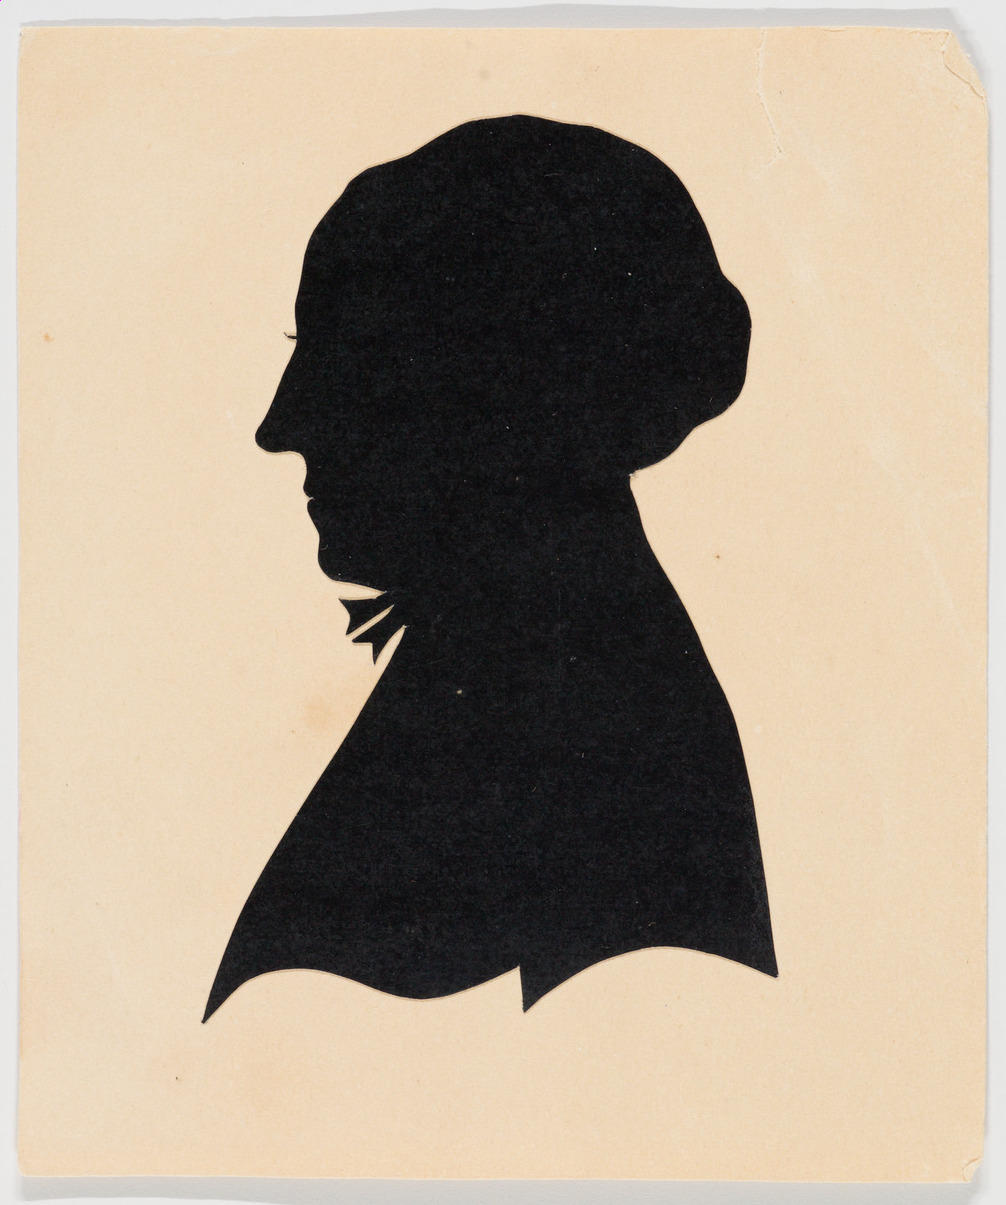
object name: cut paper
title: Unidentified profile portrait, woman facing left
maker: anonymous, german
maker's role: artist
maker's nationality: german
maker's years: 1400-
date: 1773-1820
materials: paper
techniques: cutting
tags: profiles,women